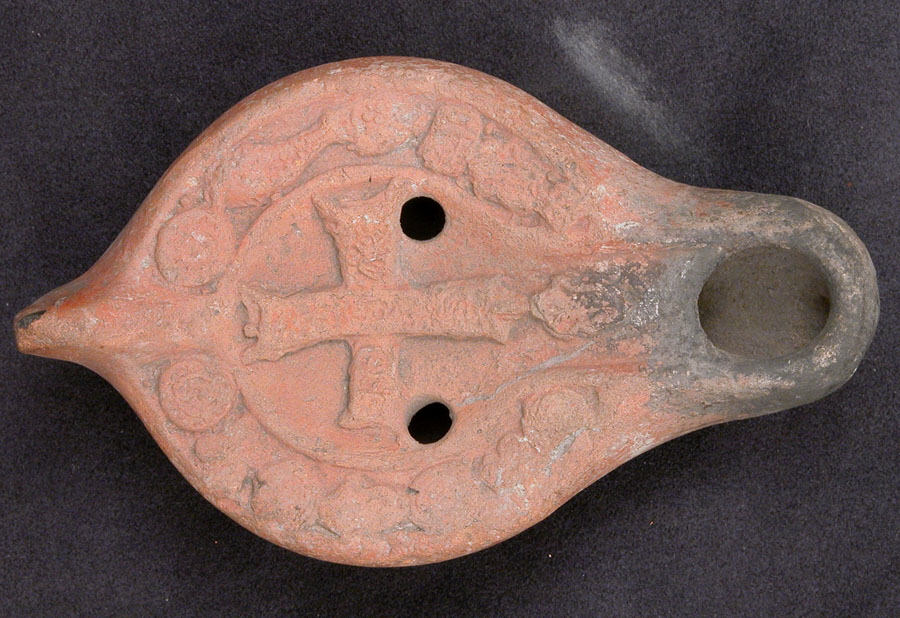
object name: lamp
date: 401-600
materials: earthenware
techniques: molding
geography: egypt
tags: fish,cross